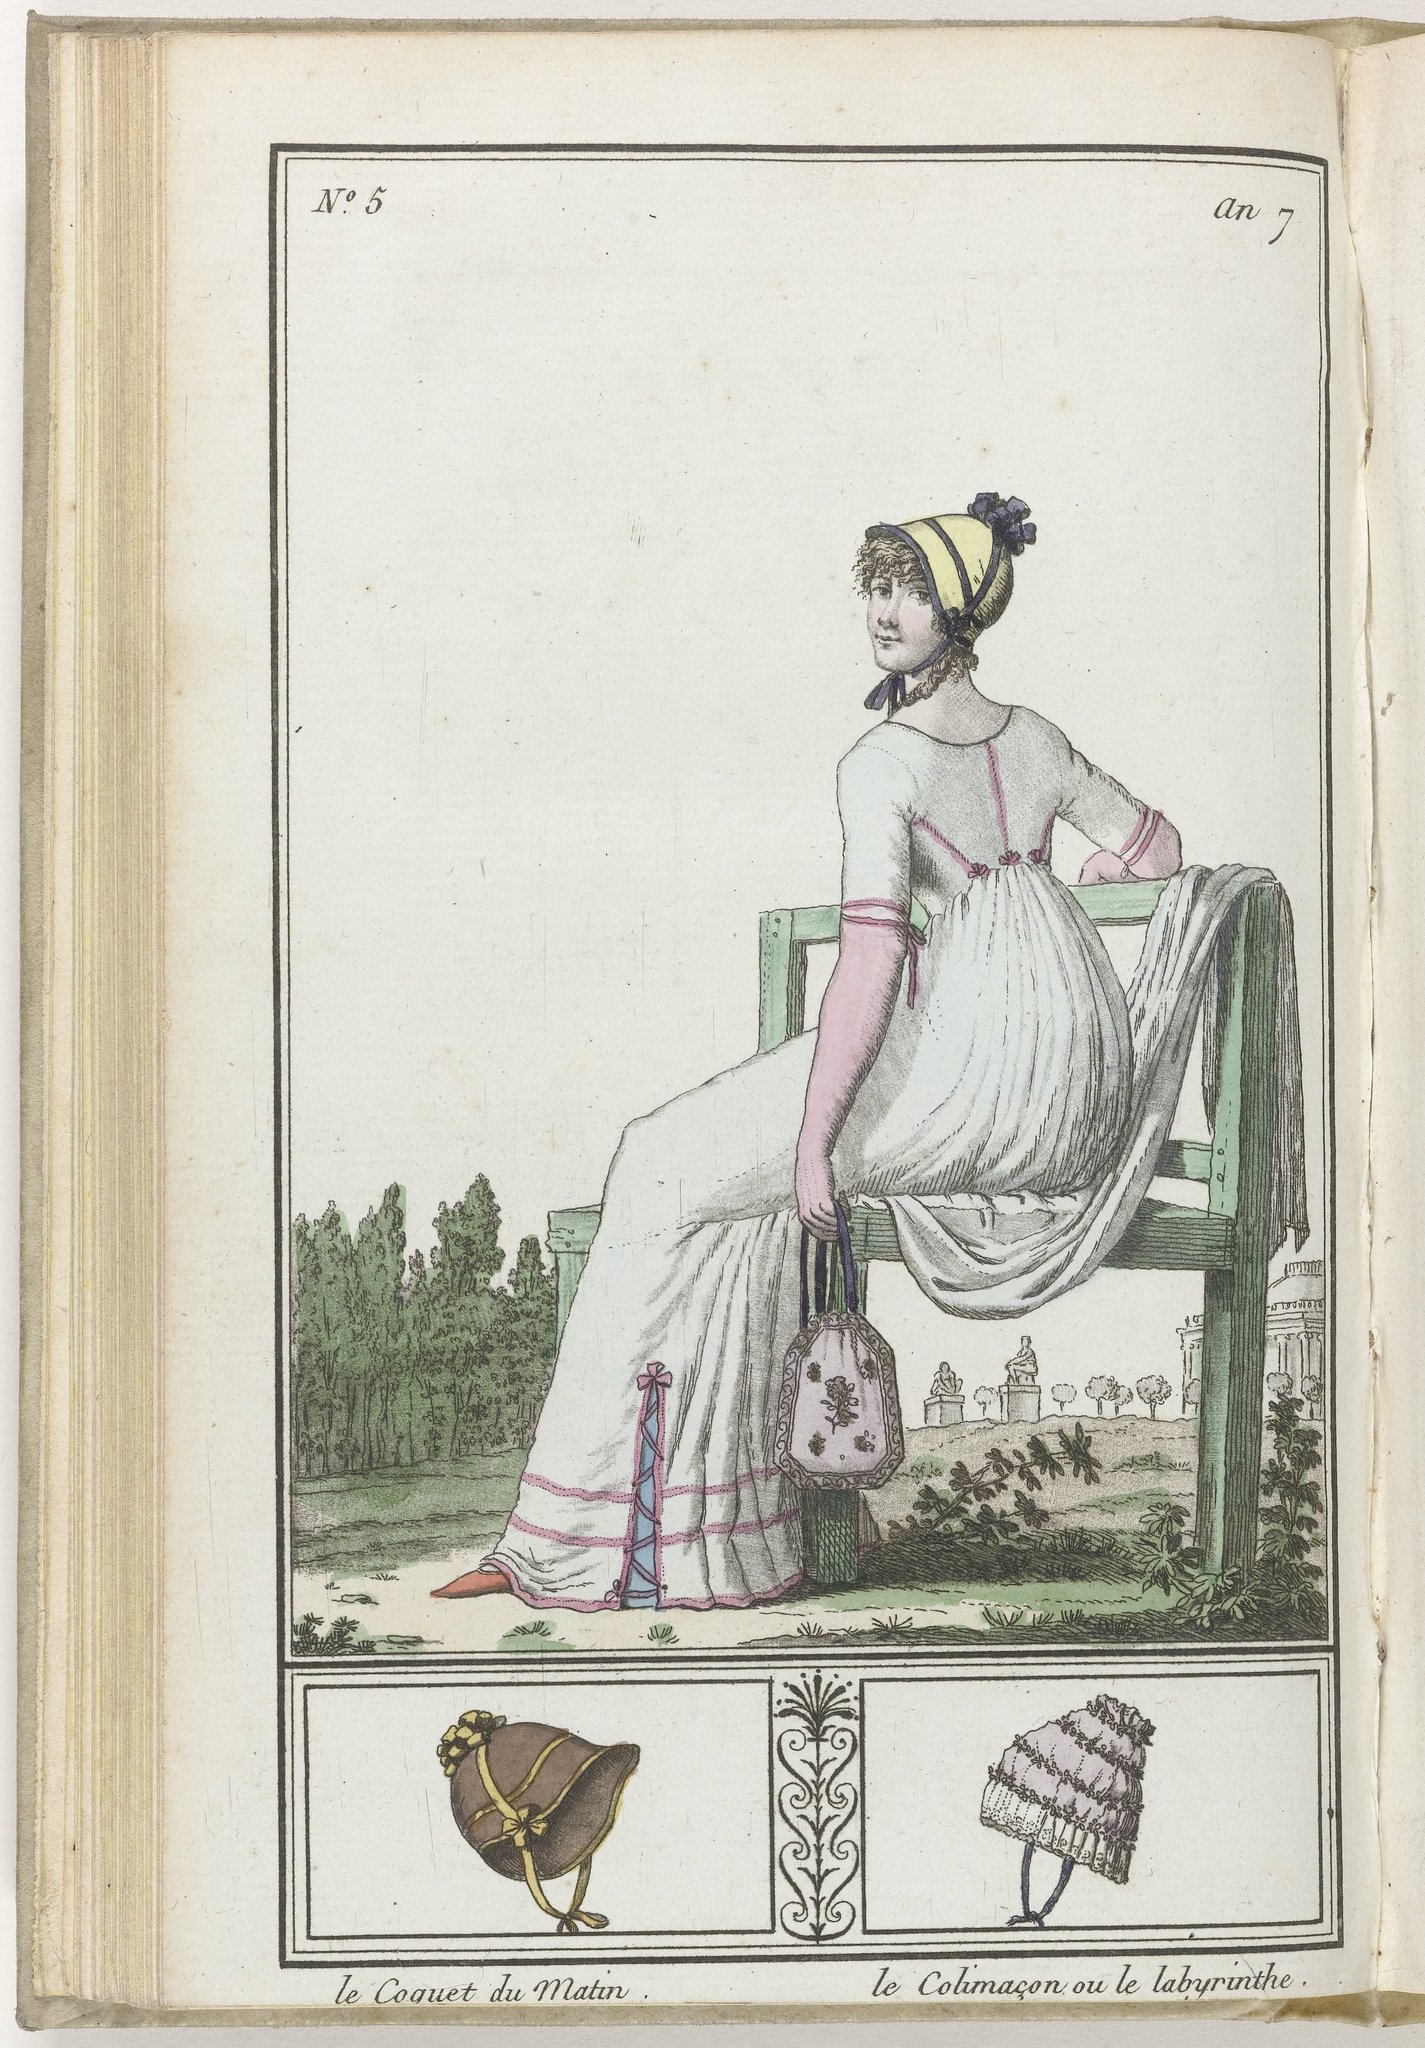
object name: fashion print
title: Le Mois, Journal historique, littéraire et critique, avec figures, Tome 2, No. 5, An. 7 (1798-1799): le Coquet du Matin...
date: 1798-1799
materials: paper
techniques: etching, hand coloring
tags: gloves, mittens (long gloves) (+ women's clothes), clothing for the upper part of the body (shawl) (+ women's clothes), bag (reticule) (+ women's clothes), head-gear: cap (+ women's clothes), fashion plates, head-gear: hat (+ women's clothes), dress, gown (+ women's clothes)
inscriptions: caption: ‘le Coquet du Matin / le Colimaçon ou le labyrinthe.’, inscription: ‘No. 5 / An. 7’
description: Jonge vrouw, zittend op een tuinbank, schuin van achteren gezien, een tasje (reticule) in de linkerhand. Onderaan twee kaders met een hoed en muts. Links: 'le Coquet du Matin'. Rechts: 'le Colimacon ou le labyrinthe'. Prent uit het tijdschrift Le Mois : Journal historique, littéraire et critique avec figures, An 7 en 8 (1798-1800).